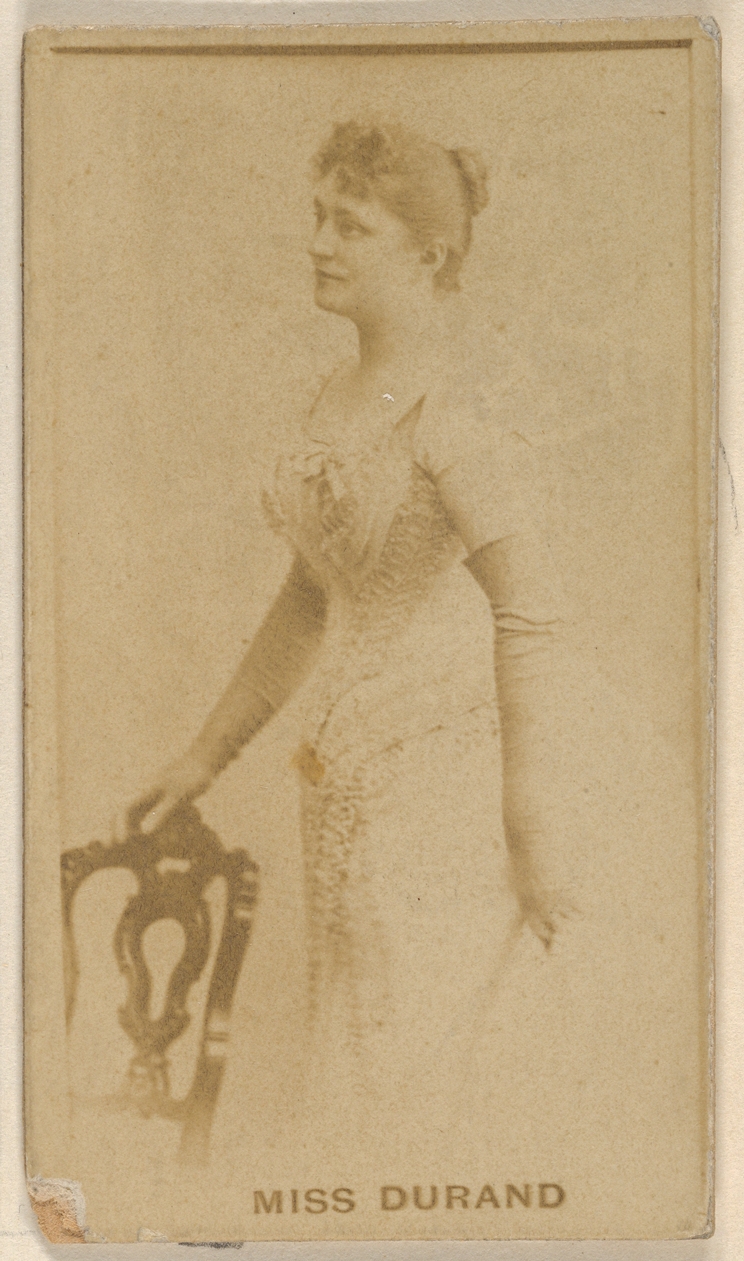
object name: photograph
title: Miss Durand, from the Actors and Actresses series (N45, Type 8) for Virginia Brights Cigarettes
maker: allen & ginter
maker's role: publisher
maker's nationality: american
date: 1888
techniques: albumen silver print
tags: portraits,women,actresses